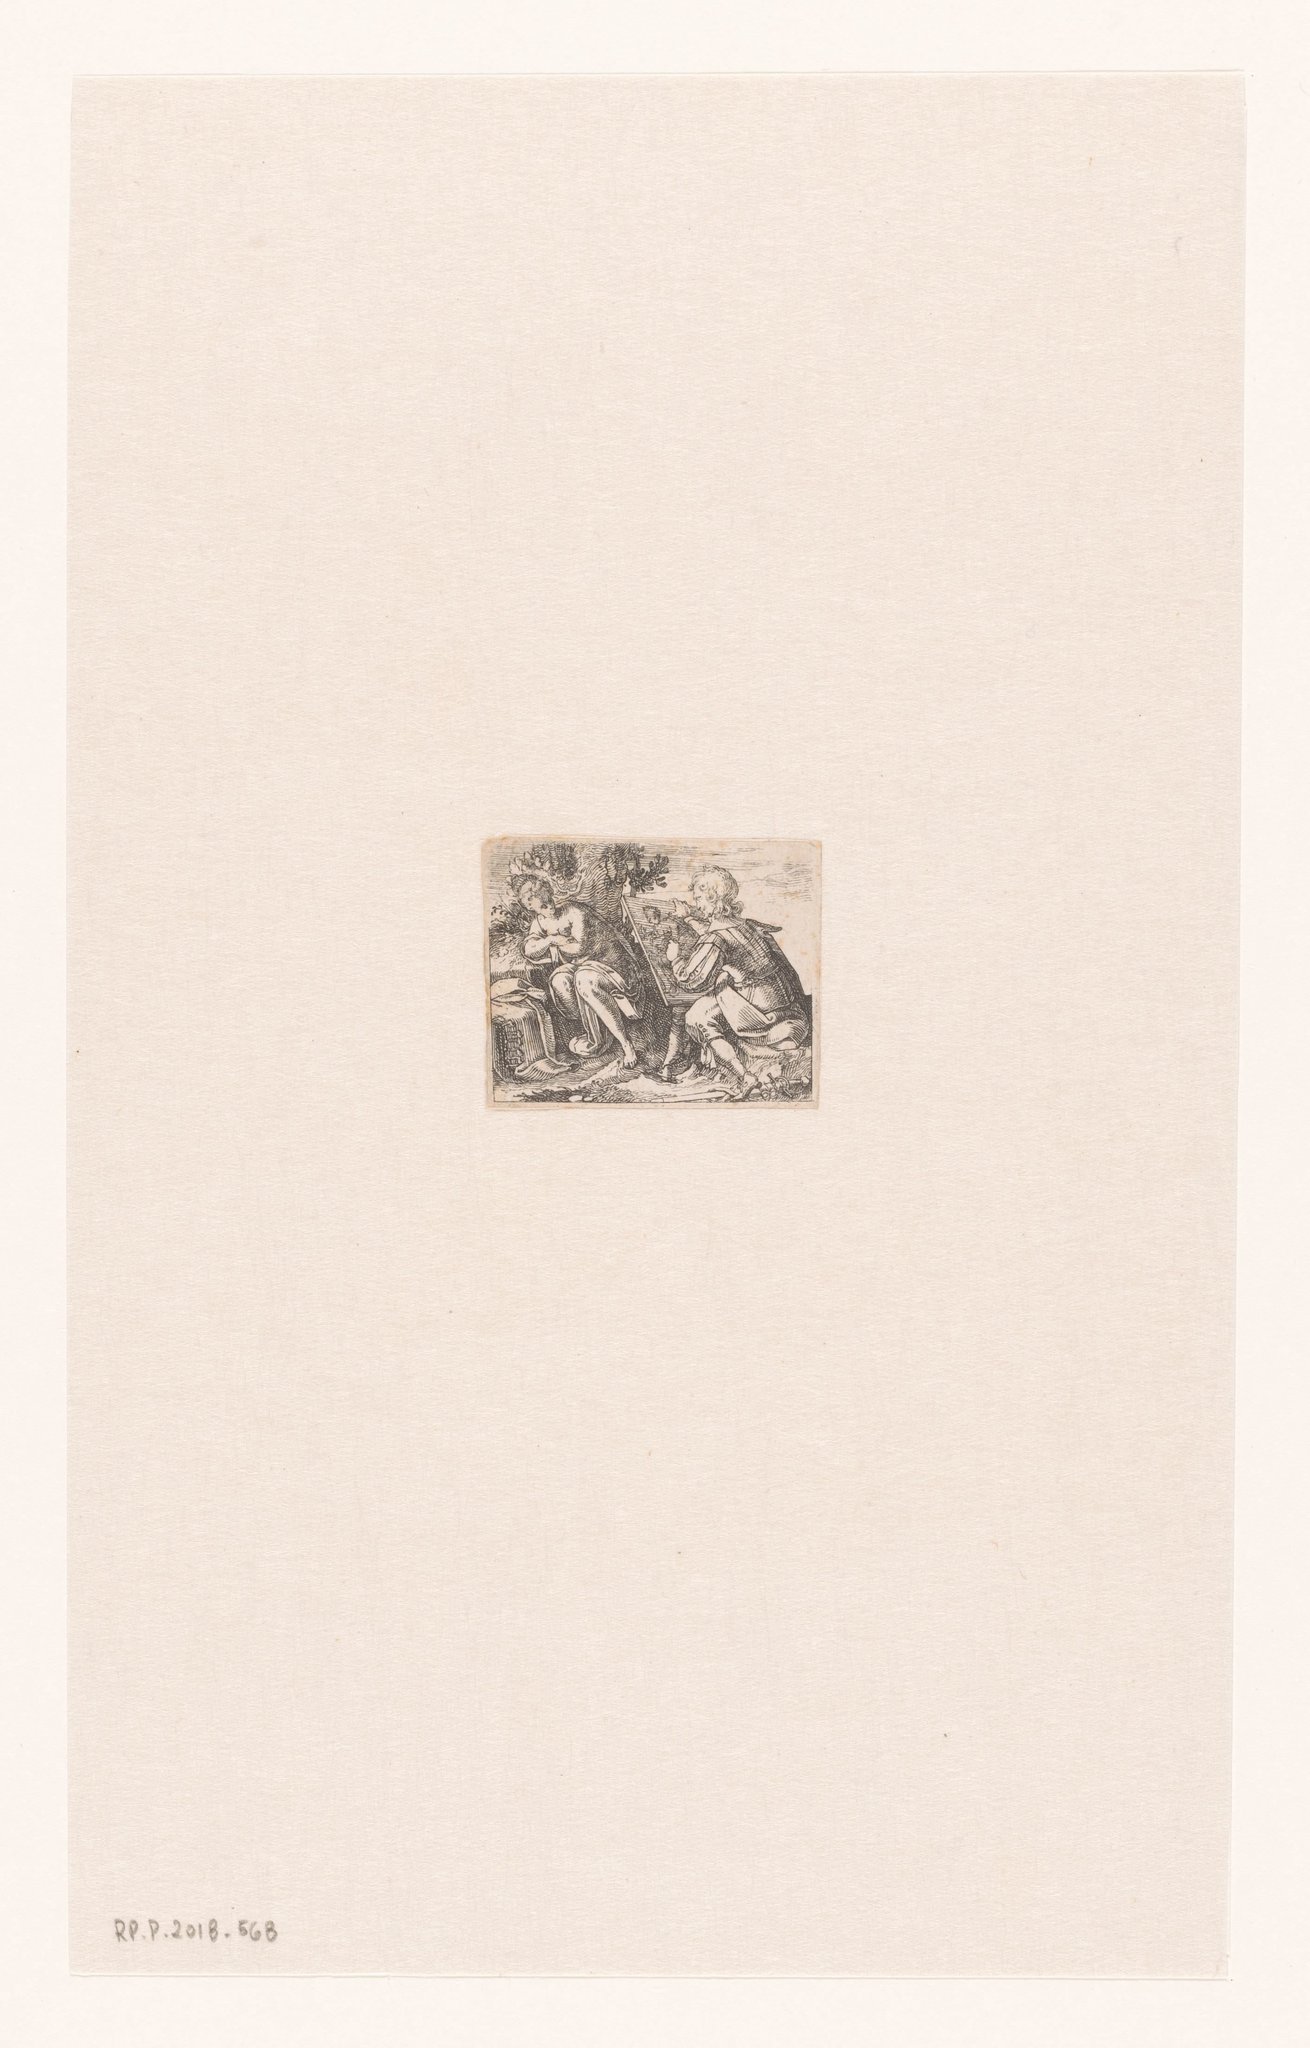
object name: print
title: De schilder met zijn model in de buitenlucht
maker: rudolph meyer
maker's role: print maker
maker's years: 1605-1638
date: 1615-1638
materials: paper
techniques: etching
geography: zurich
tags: artist (in general) working from live model - bb - out of doors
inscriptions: collector's mark: Lugt 2228